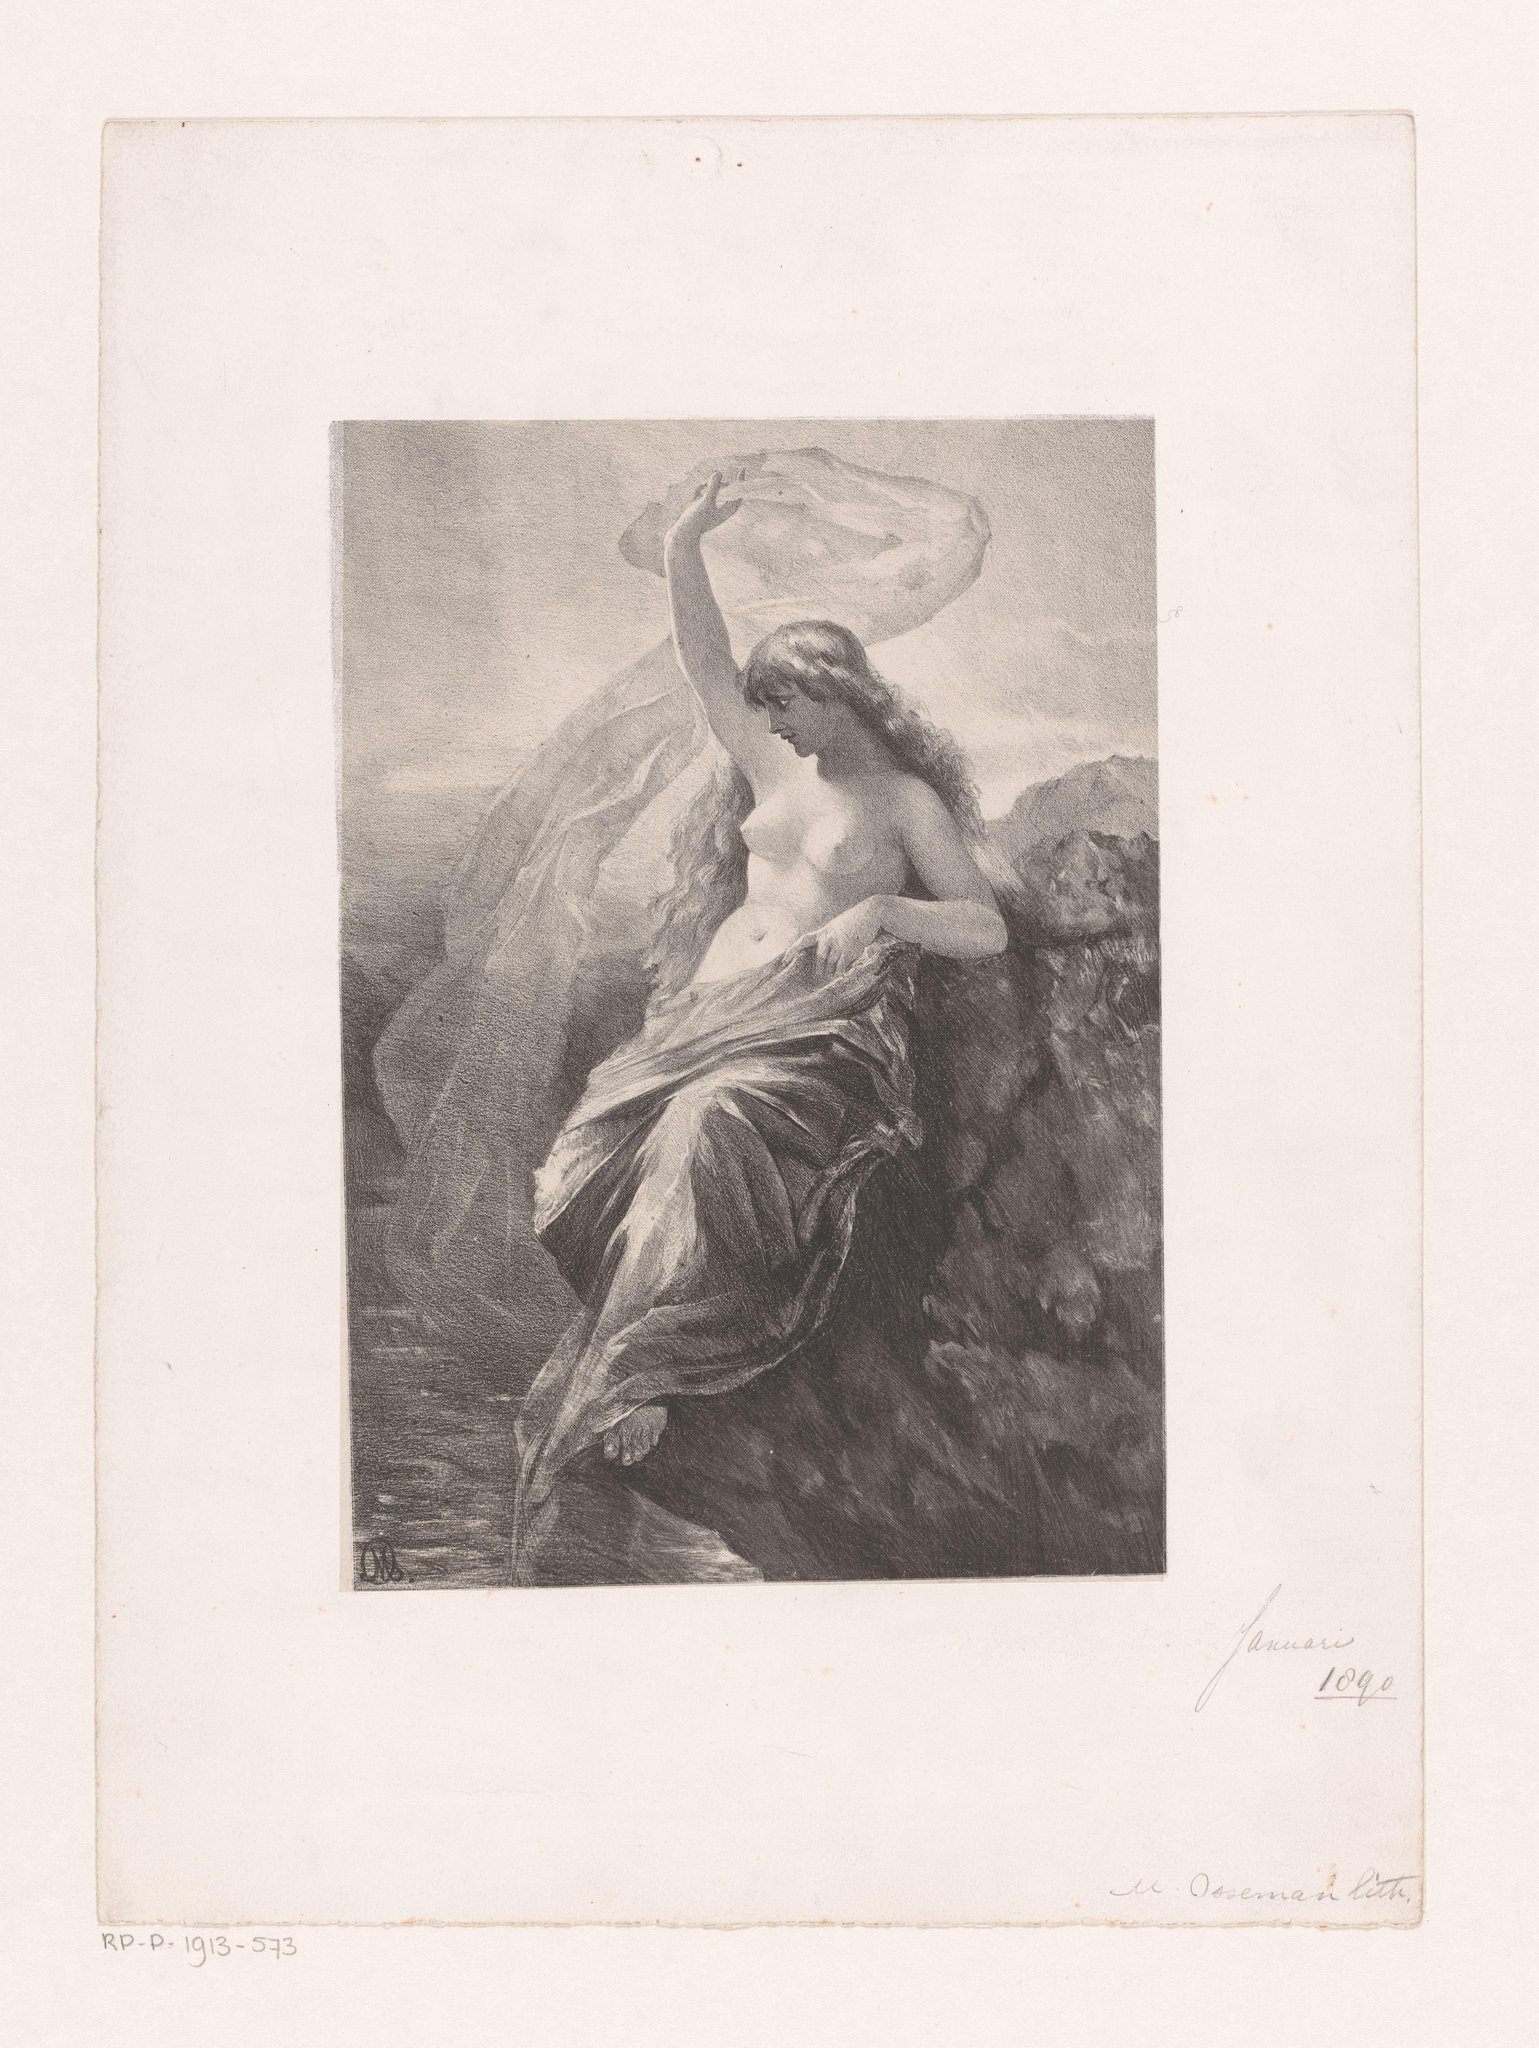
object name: print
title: Nimf van de Loreley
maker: maria osseman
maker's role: print maker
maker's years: 1871-1935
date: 1890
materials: paper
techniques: lithograph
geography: netherlands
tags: nymphs (in general); 'ninfe in commune' (ripa)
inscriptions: collector's mark: Lugt 2233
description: Op een rots zit een half ontblote vrouw met doek in haar hand.